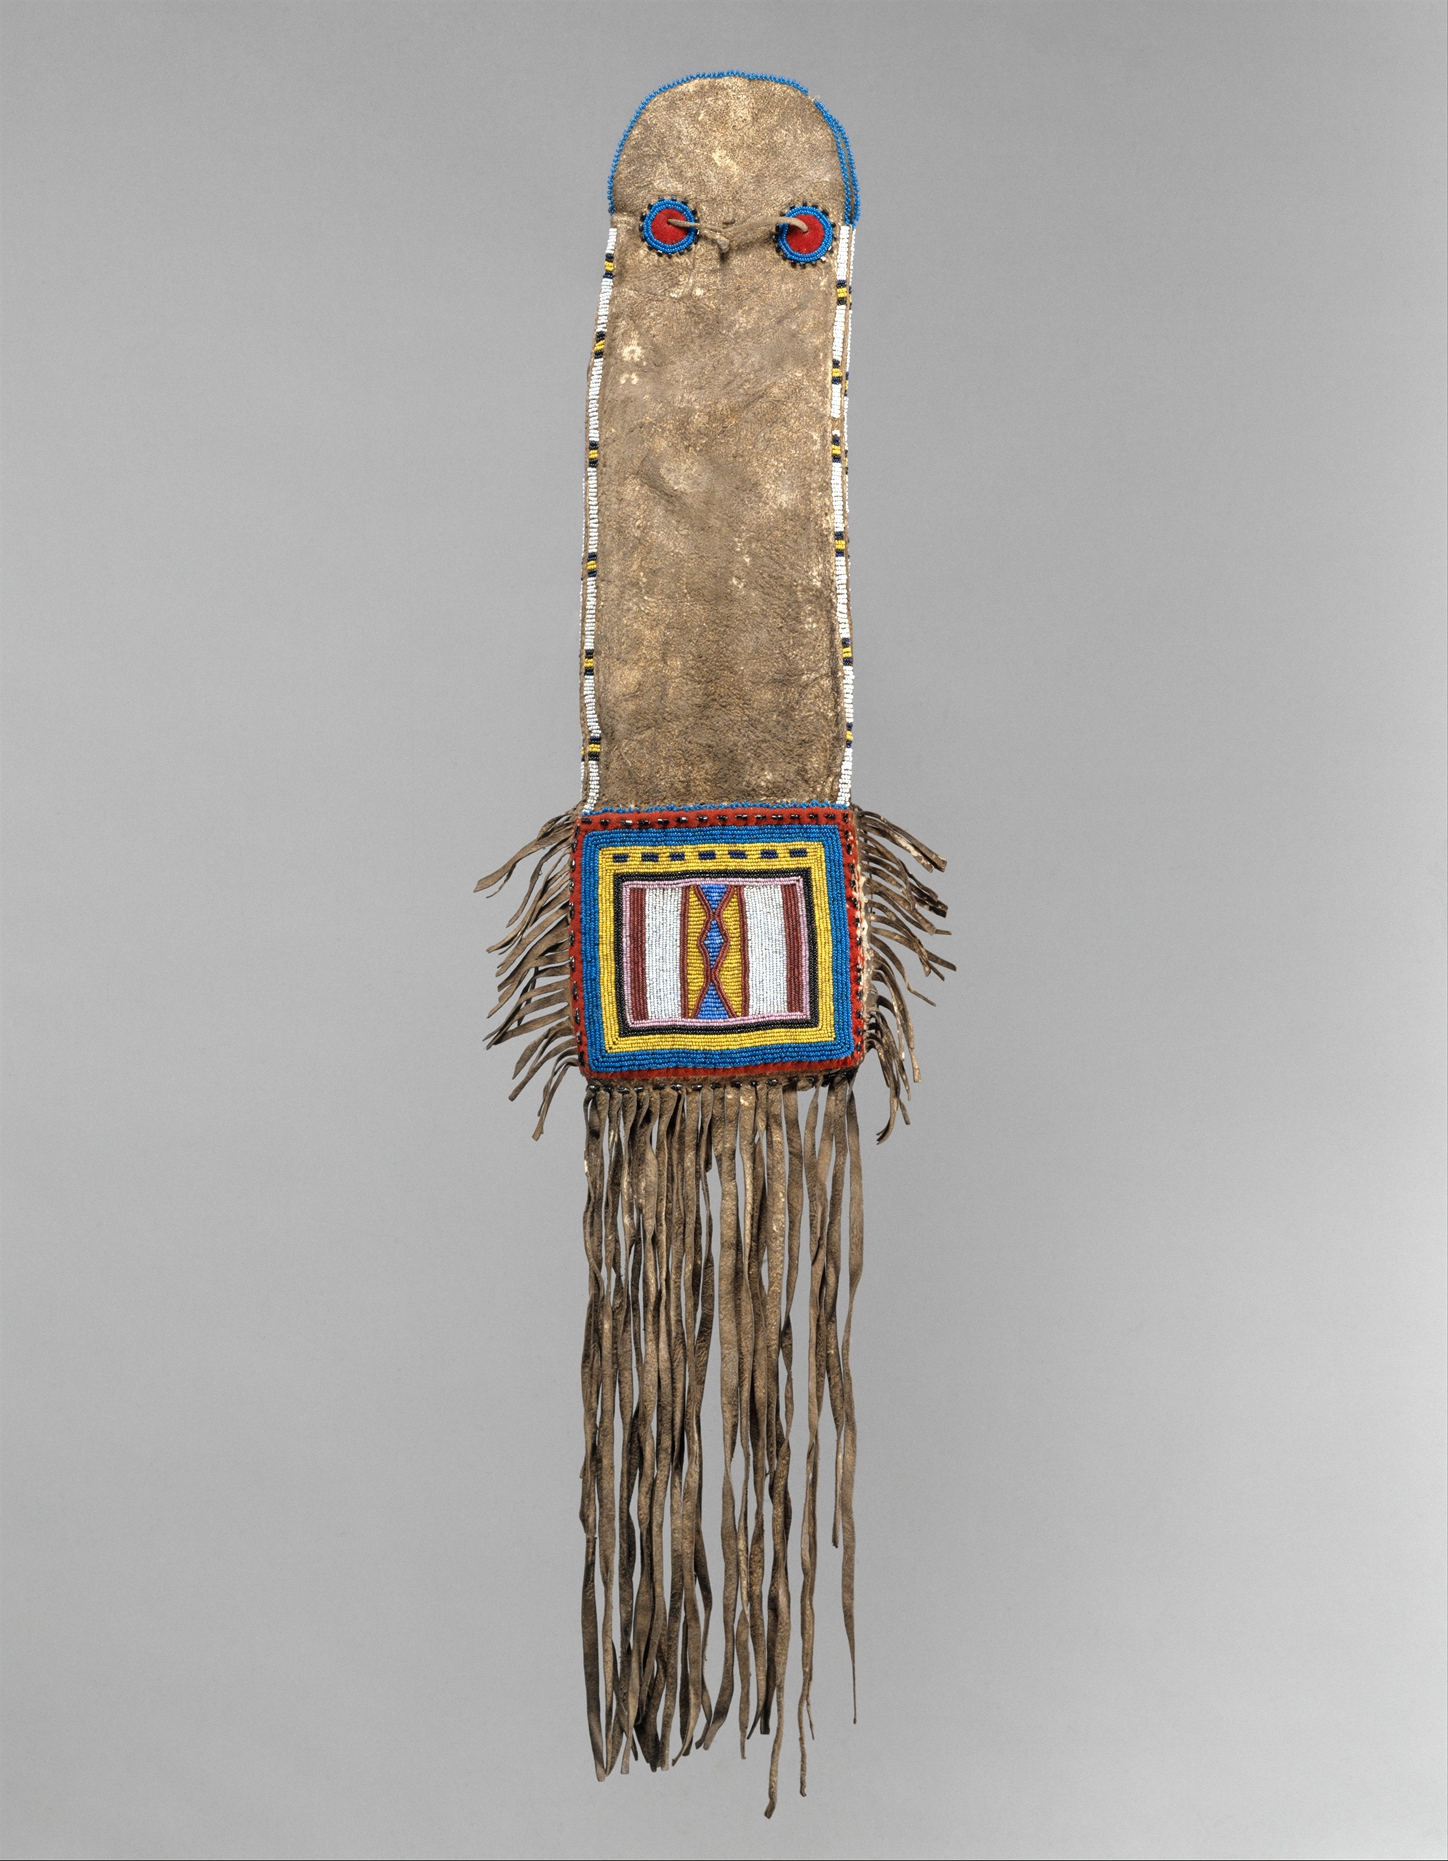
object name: tobacco bag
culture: assiniboine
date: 1860-1870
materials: glass, skin, wool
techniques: tanning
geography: canada